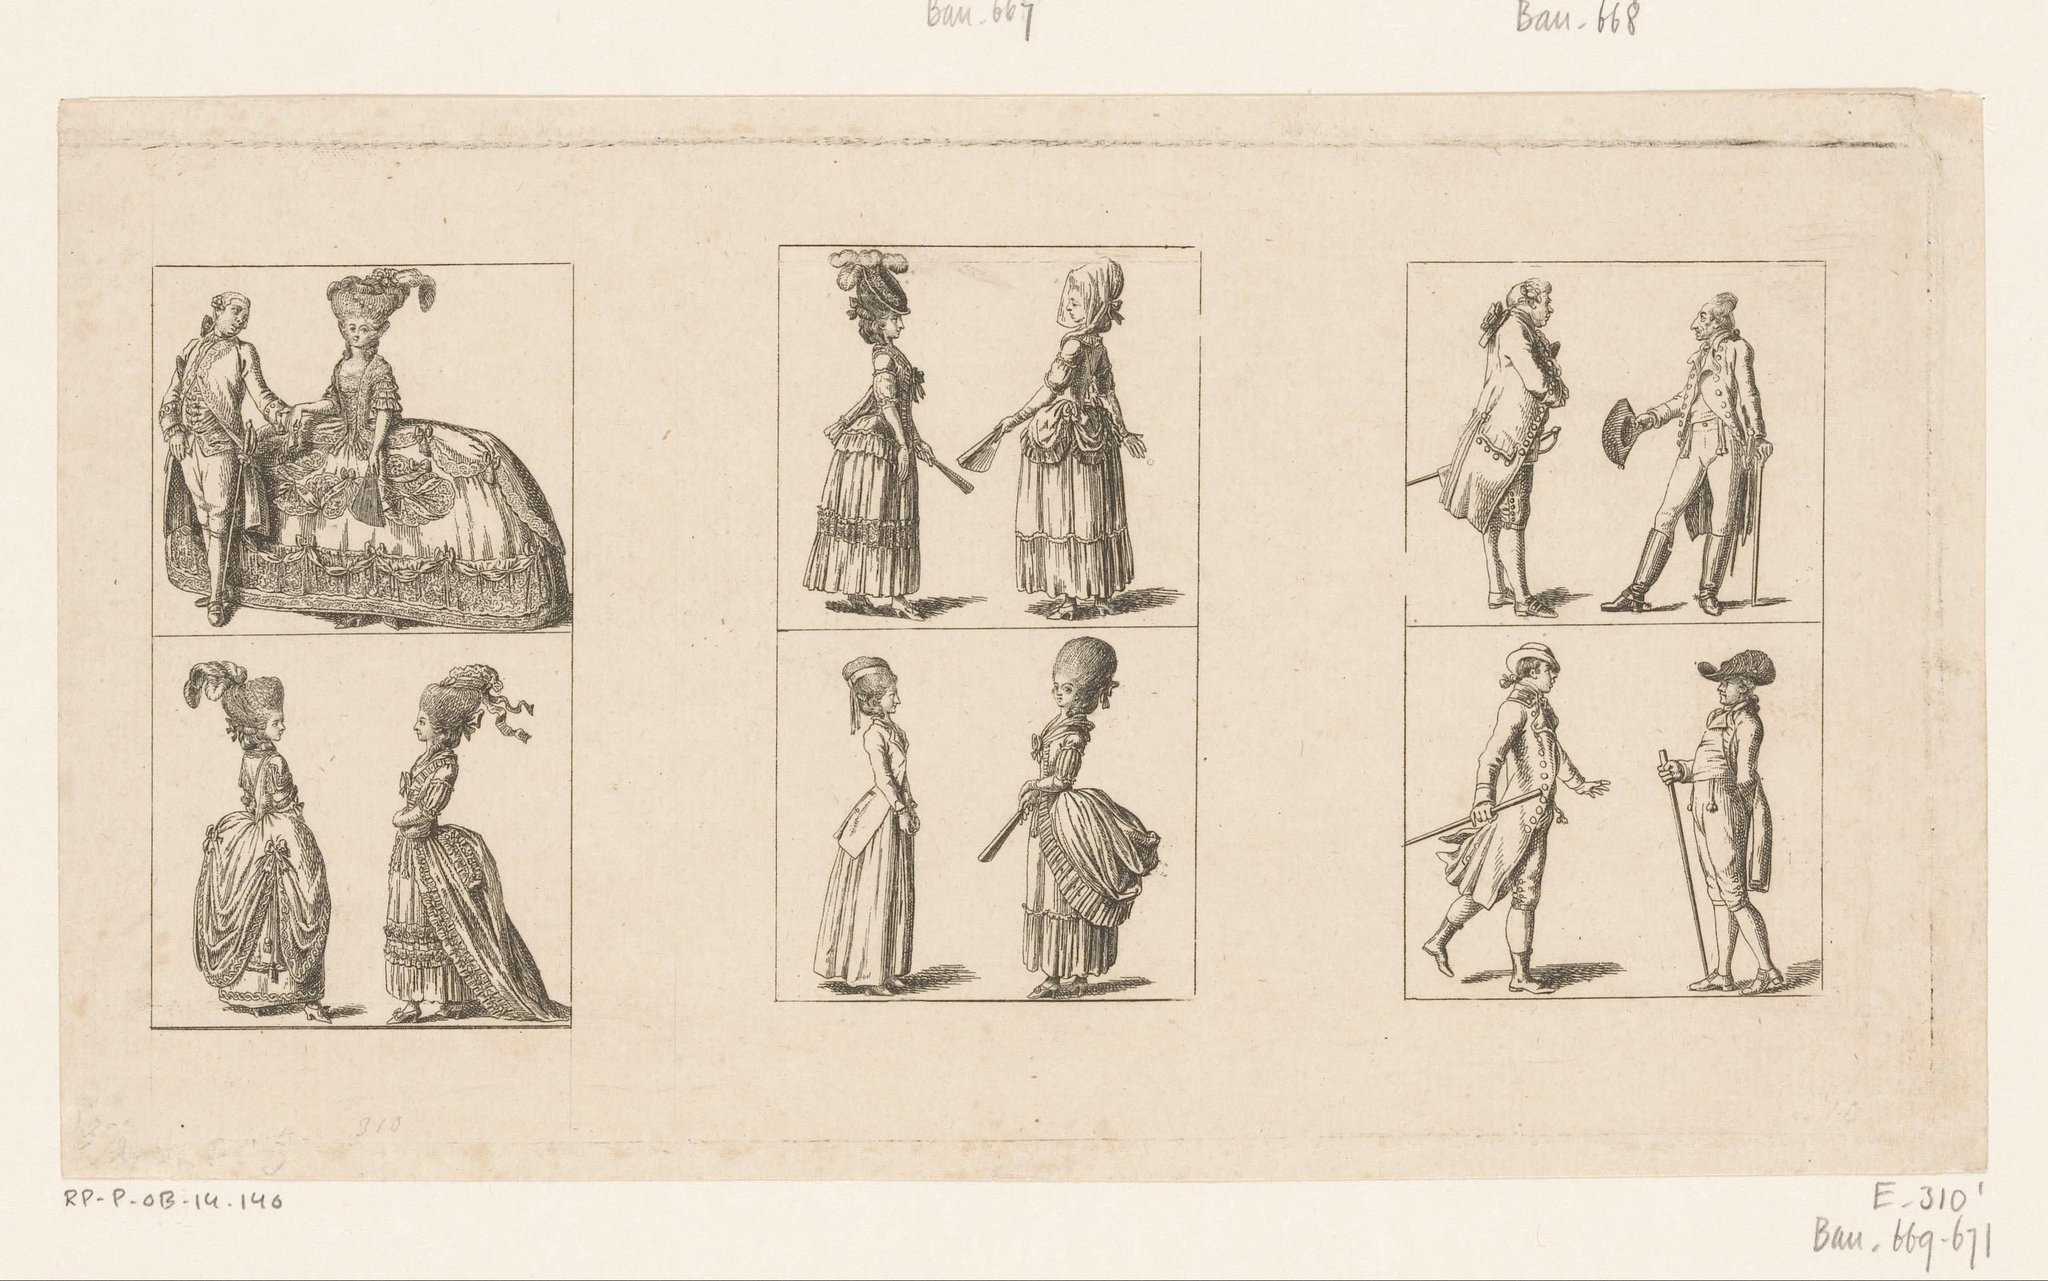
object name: print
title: Dames- en herenkleding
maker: daniel nikolaus chodowiecki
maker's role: draughtsman, print maker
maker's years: 1726-1801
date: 1779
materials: paper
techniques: etching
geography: berlin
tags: fashion, clothing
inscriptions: collector's mark: Lugt 2228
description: Een latere staat van deze prent is ook gebruikt in: Lauenburger genealogischen Kalender auf das Jahr 1780.